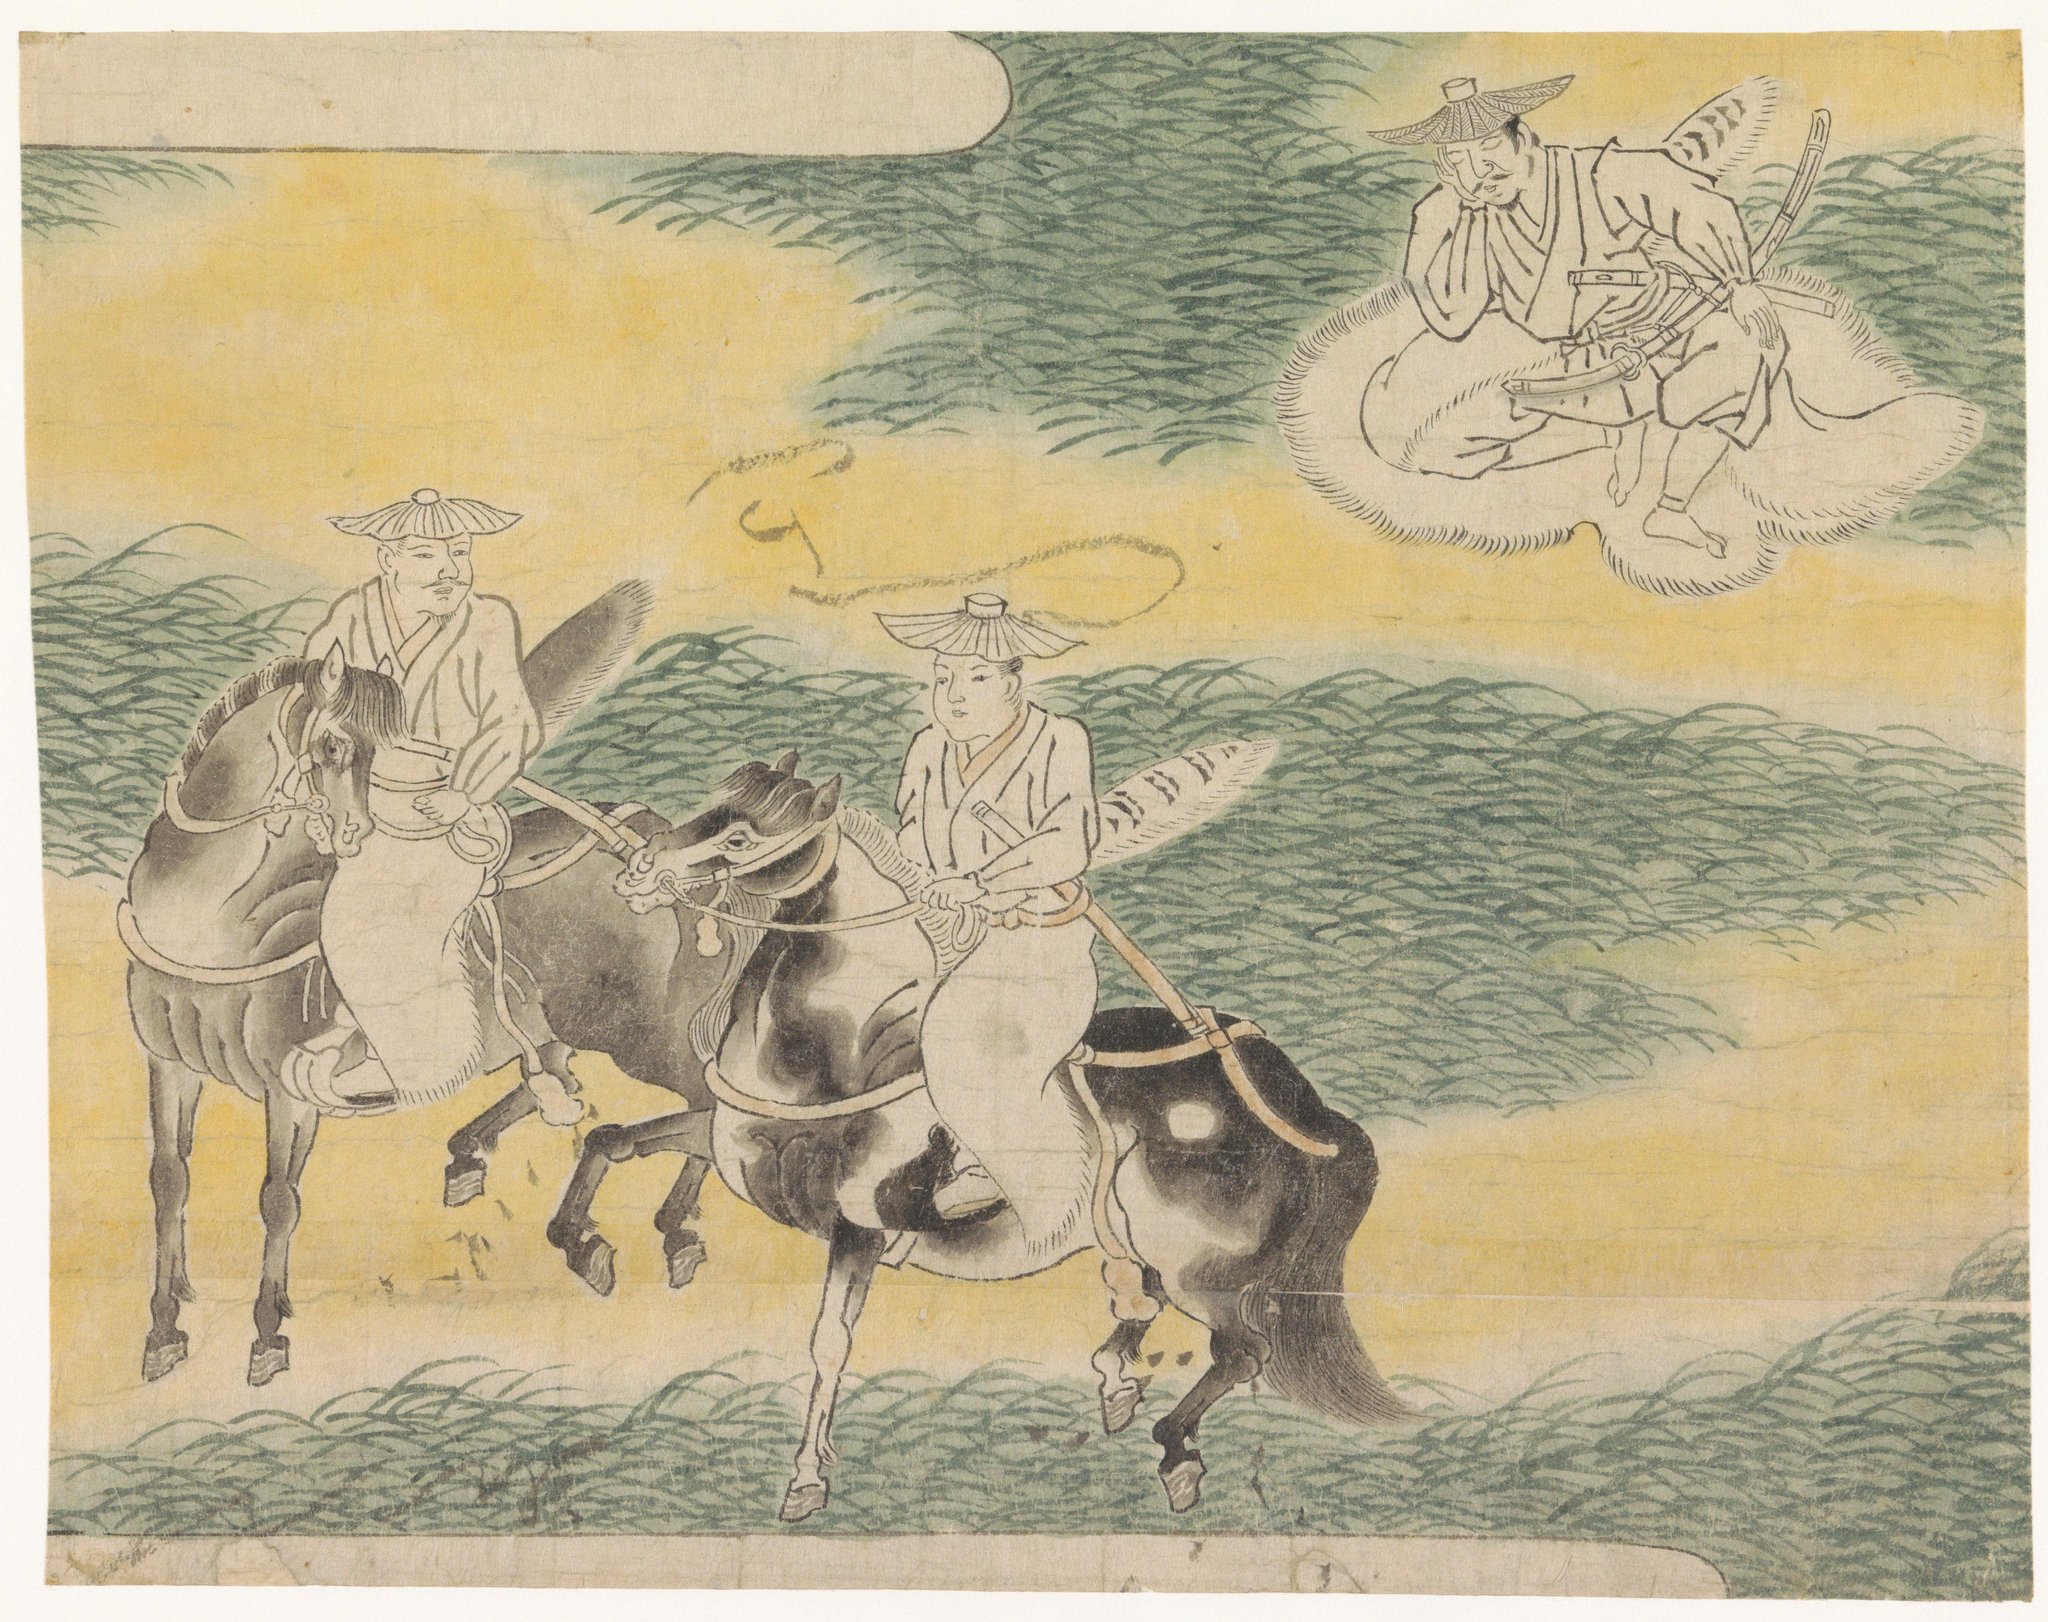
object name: drawing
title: Twee ruiters te paard en rechts een slapende samoerai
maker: Anonymous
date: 1800-1900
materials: paper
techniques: brush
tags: sleeping; unconsciousness